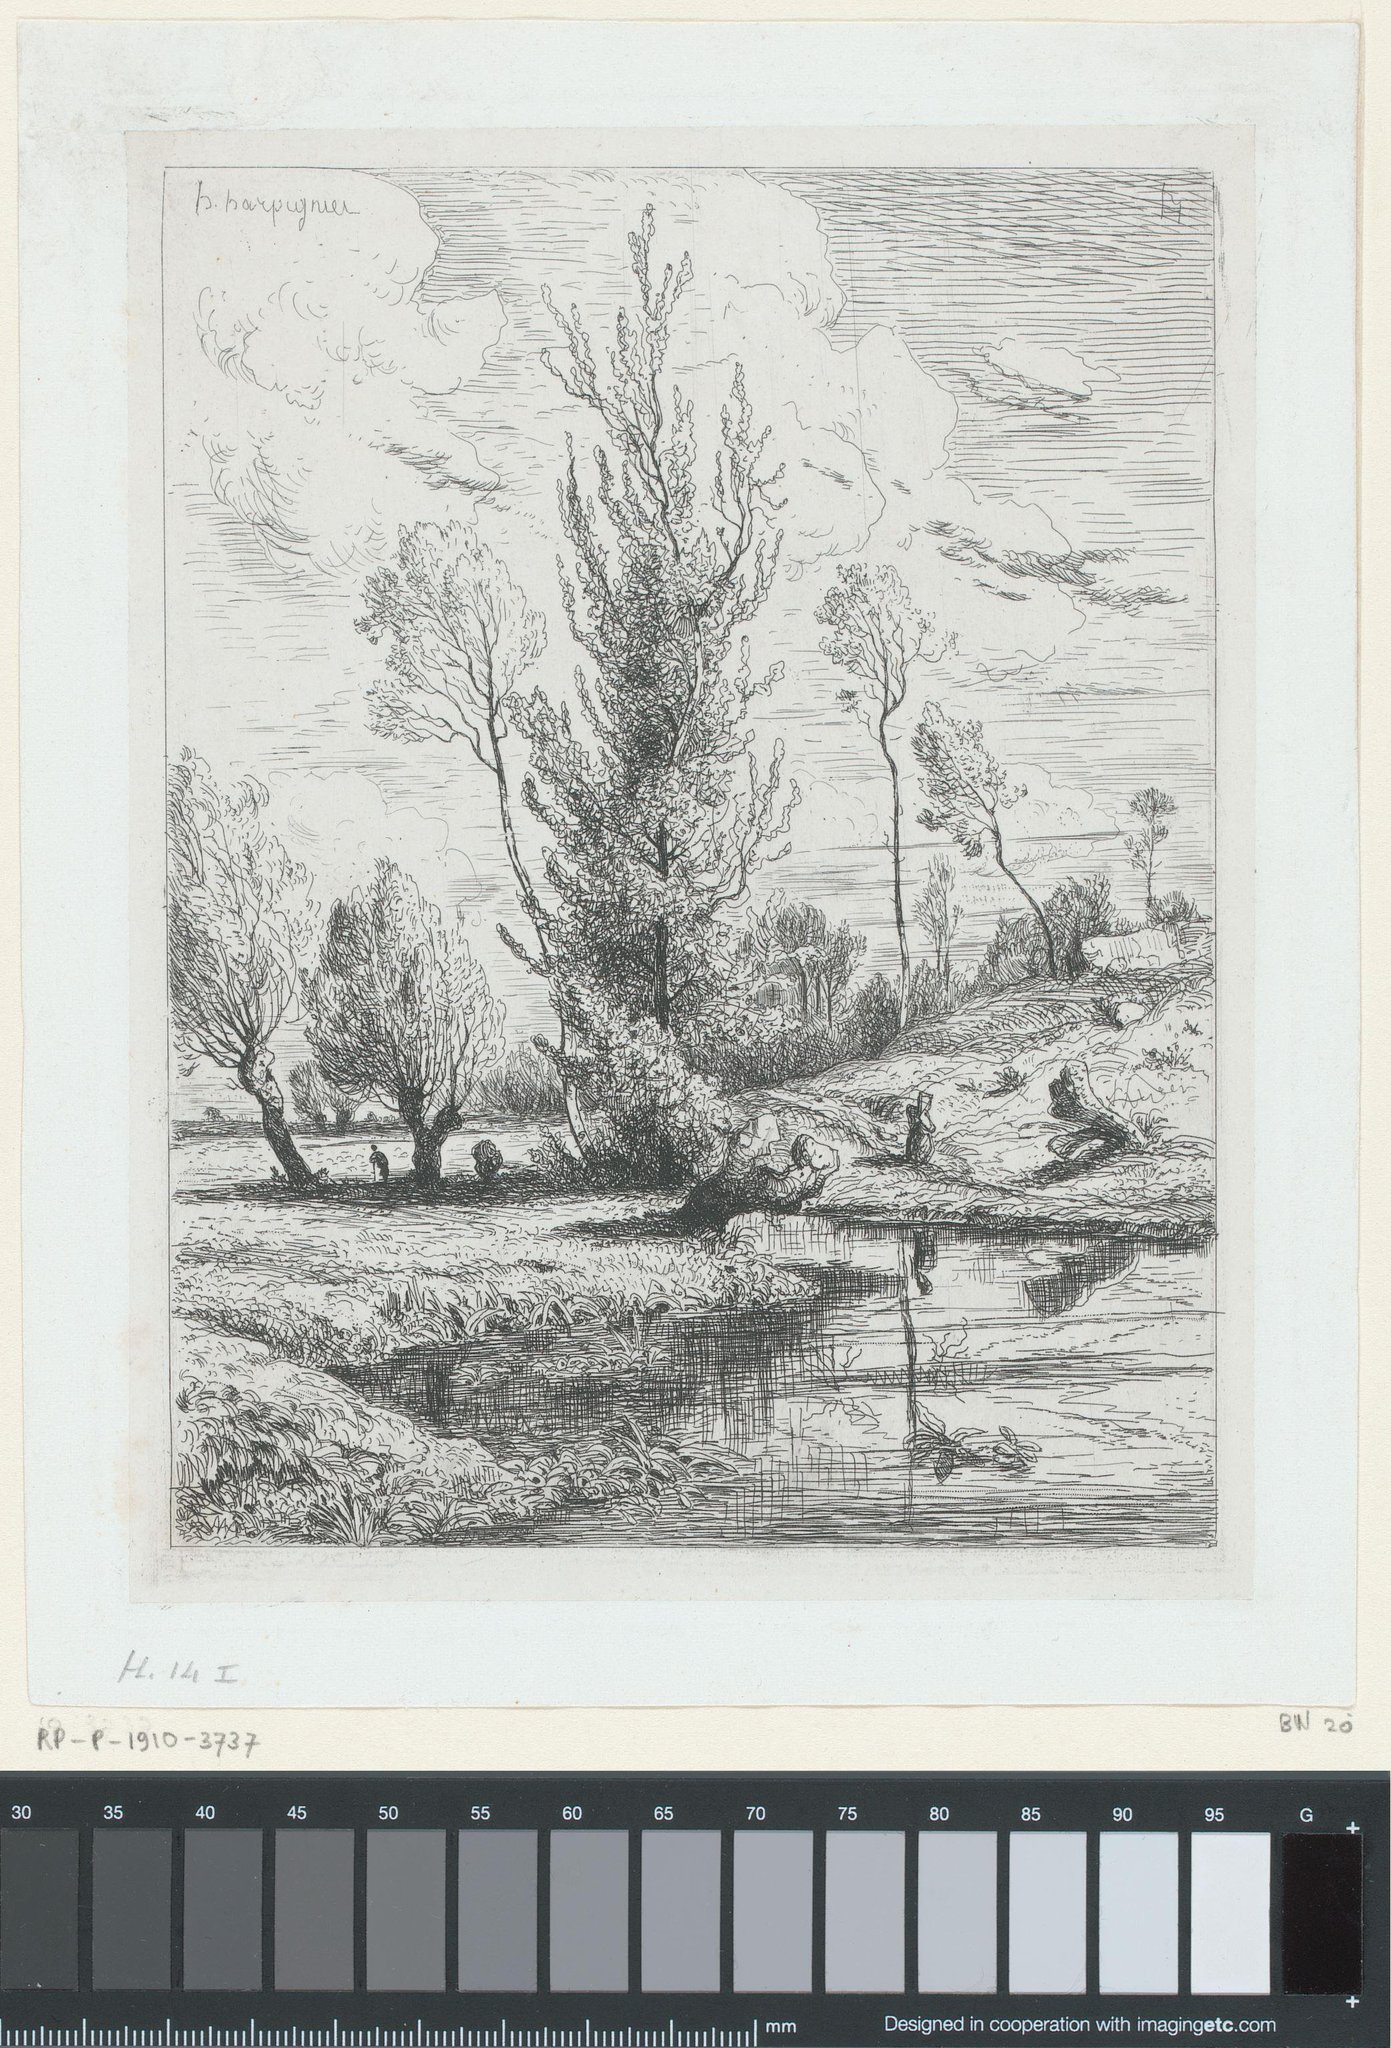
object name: print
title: Landschap met bomen bij een plas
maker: henri joseph harpignies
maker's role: draughtsman, print maker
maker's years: 1819-1916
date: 1853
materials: paper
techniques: etching, roulette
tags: landscapes, pond, pool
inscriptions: collector's mark: Lugt 1485